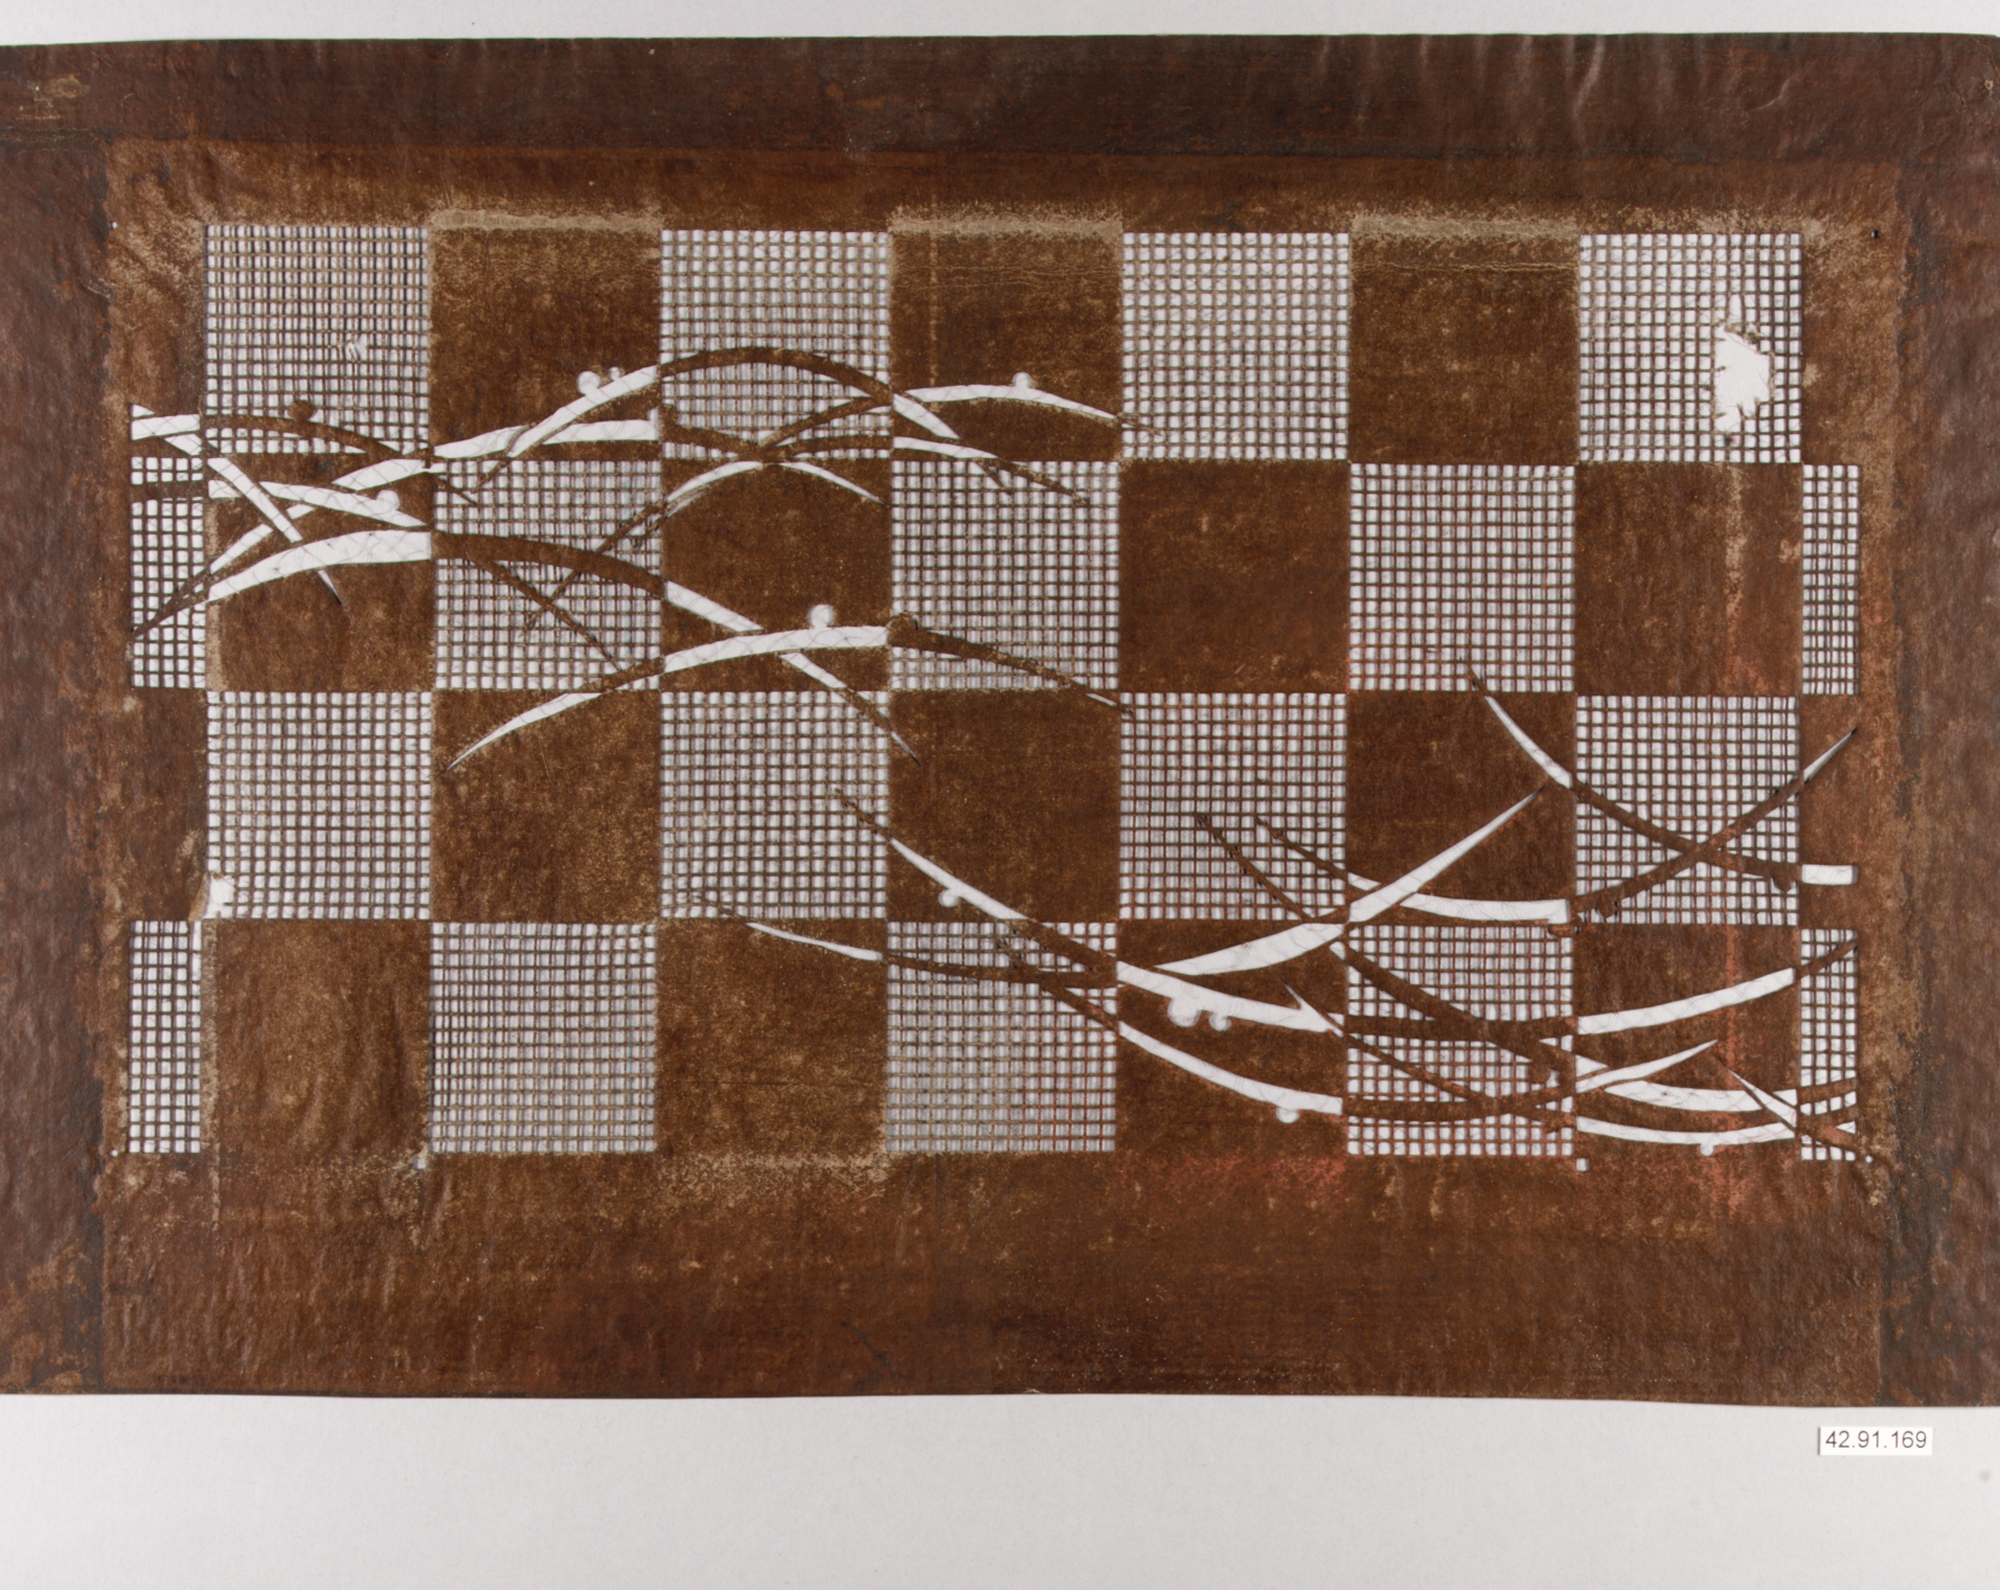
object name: stencil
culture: japanese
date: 1801-1900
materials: paper